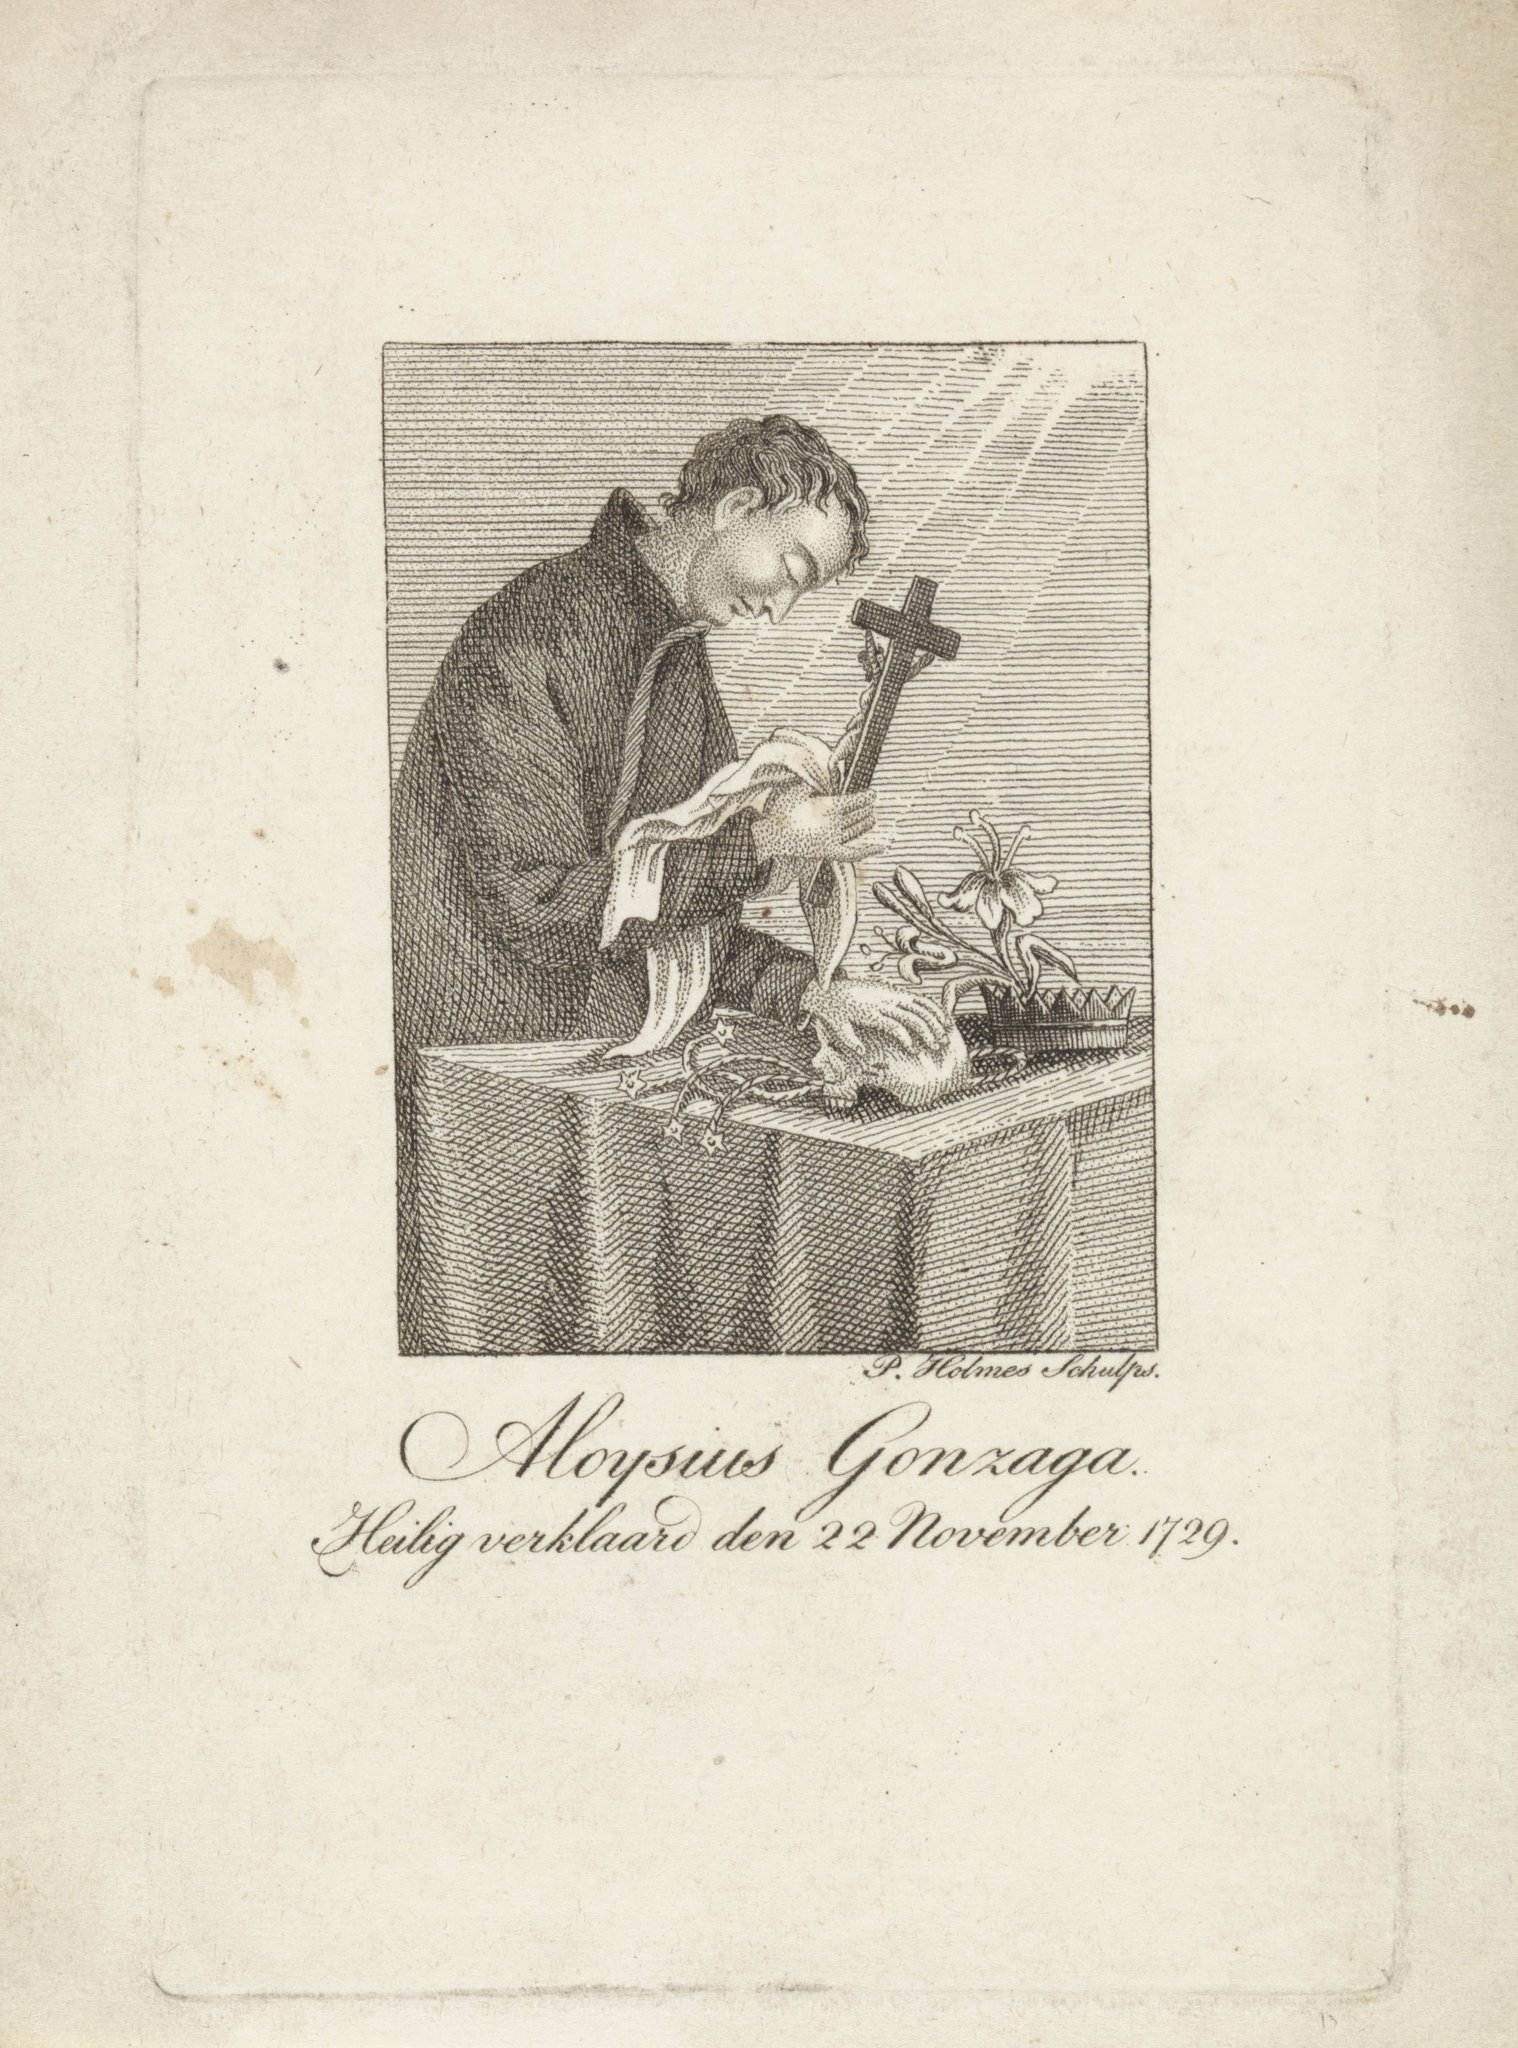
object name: print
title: Biddende heilige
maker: pieter holmes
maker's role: print maker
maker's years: 1788-1853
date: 1798-1853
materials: parchment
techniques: etching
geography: amsterdam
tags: st. aloysius gonzaga in ecstasy before an altar with crucifix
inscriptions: collector's mark: Lugt 2228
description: De heilige Aloysius Gonzaga met een crucifix in zijn hand. Zijn andere hand houdt hij op een schedel die voor hem op een tafel ligt, naast een lelie en een kroon. Hij wordt beschenen door lichtstralen. Onder de voorstelling twee regels in het Nederlands.